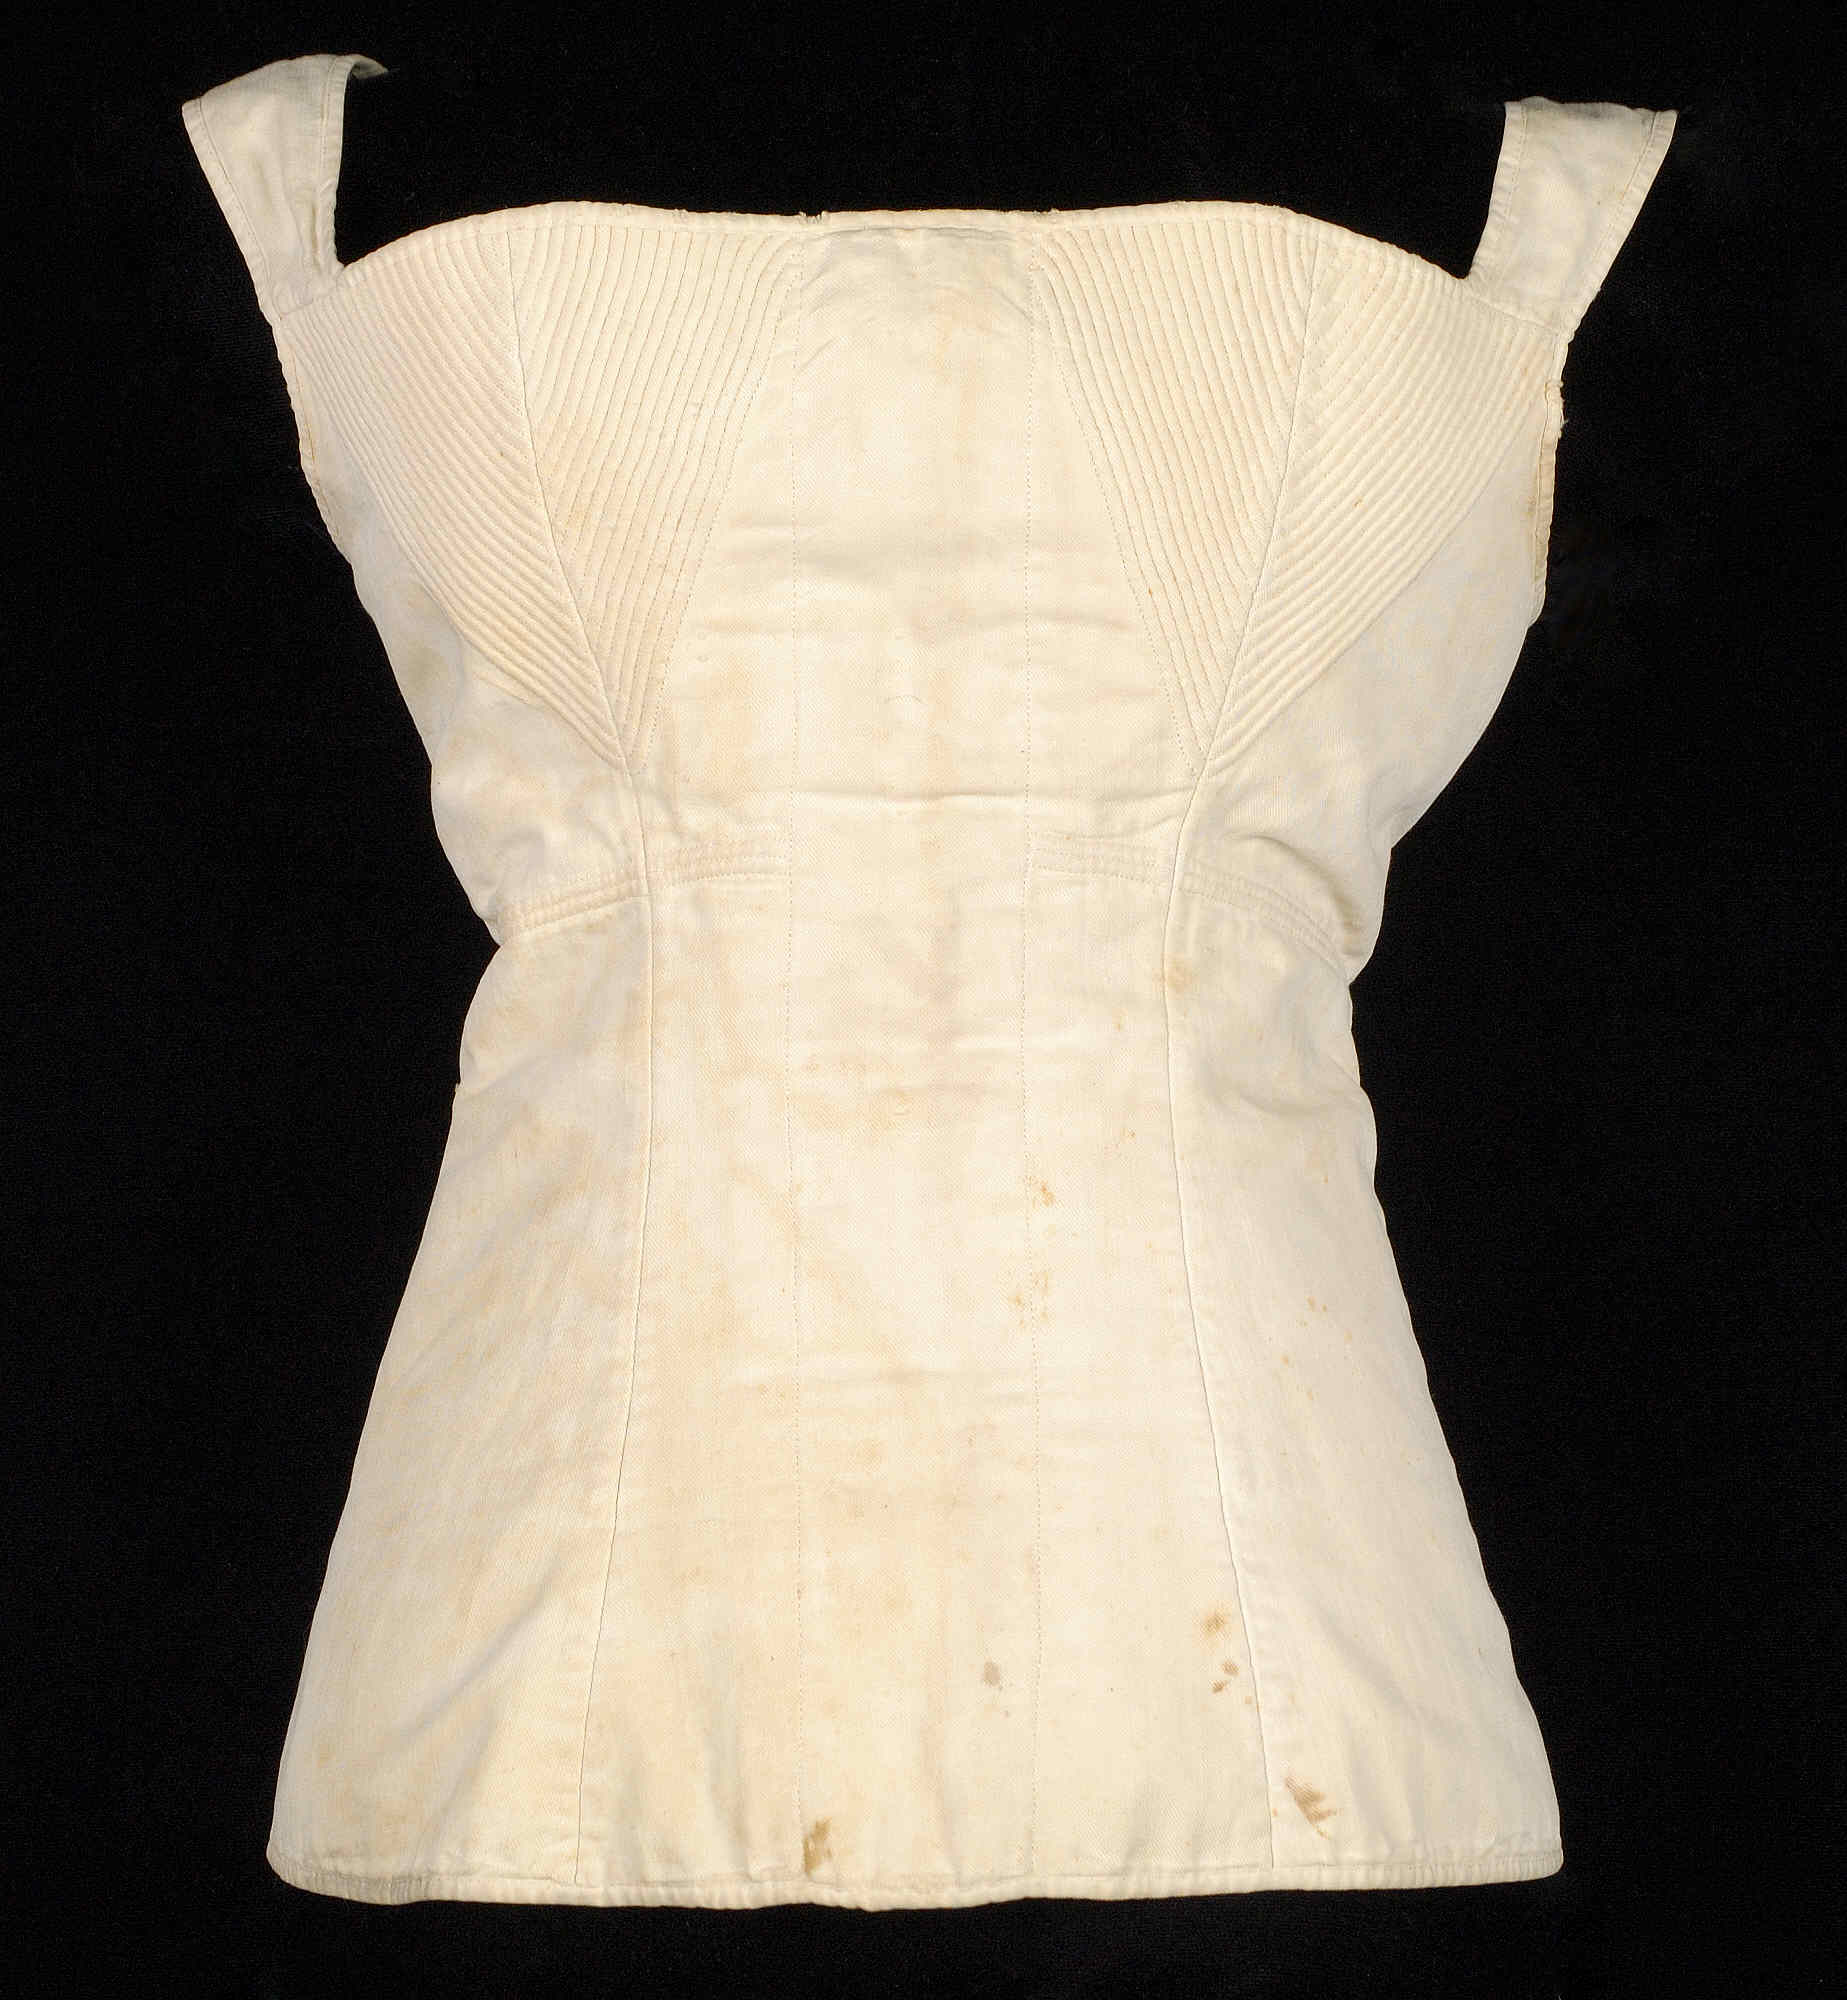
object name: corset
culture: american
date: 1830-1839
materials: cotton